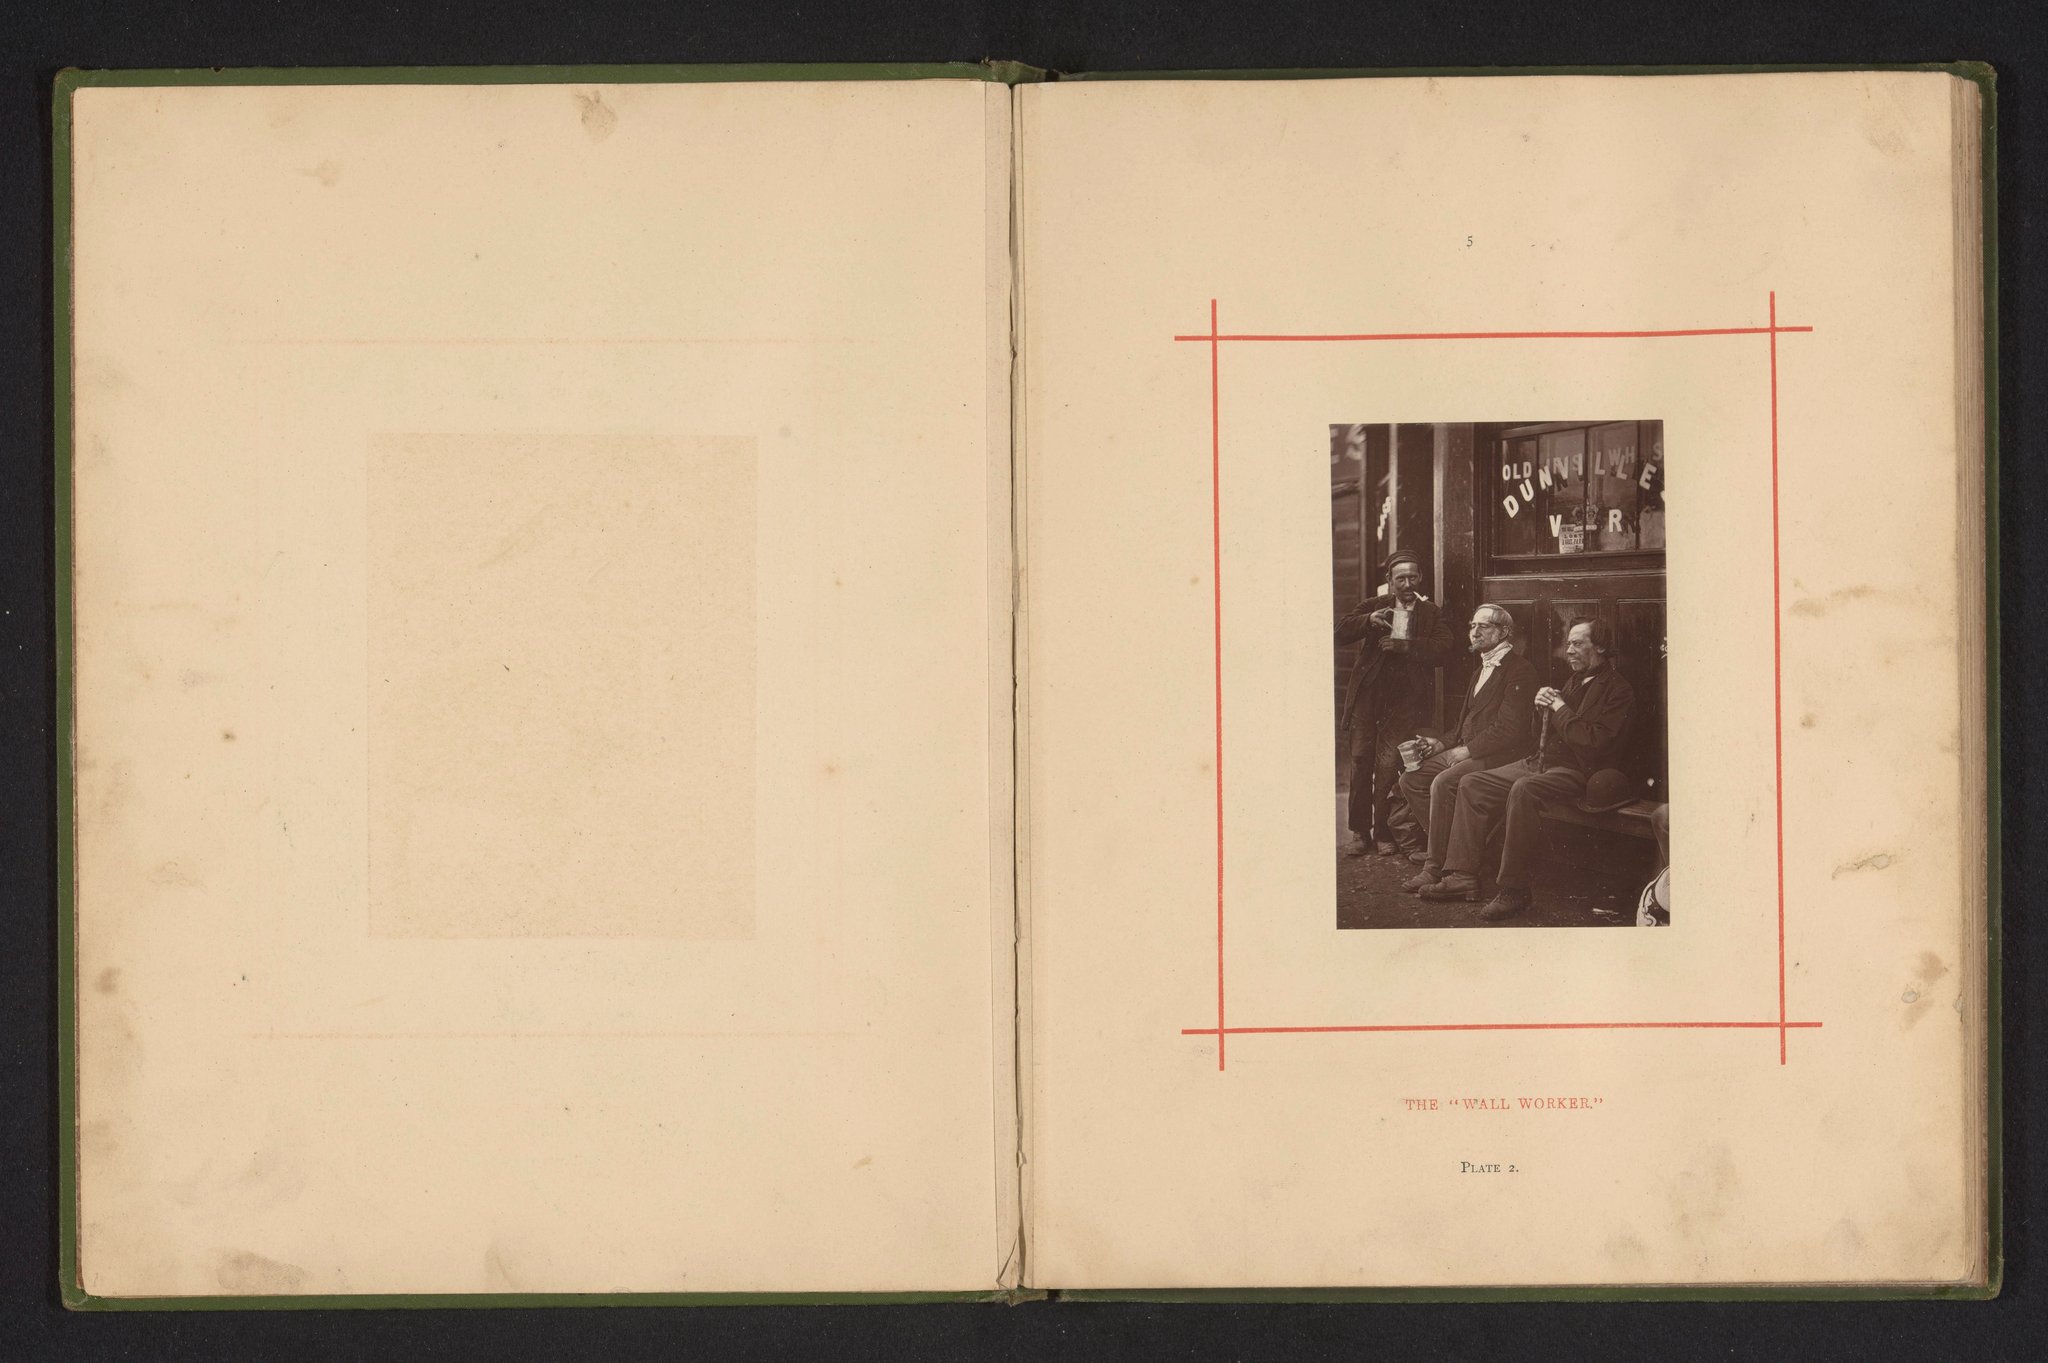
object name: photomechanical print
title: The "wall worker"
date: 1871-1881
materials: paper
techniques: woodburytype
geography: london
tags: bench, sitting figure, bill-board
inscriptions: number: ‘Plate 2.’